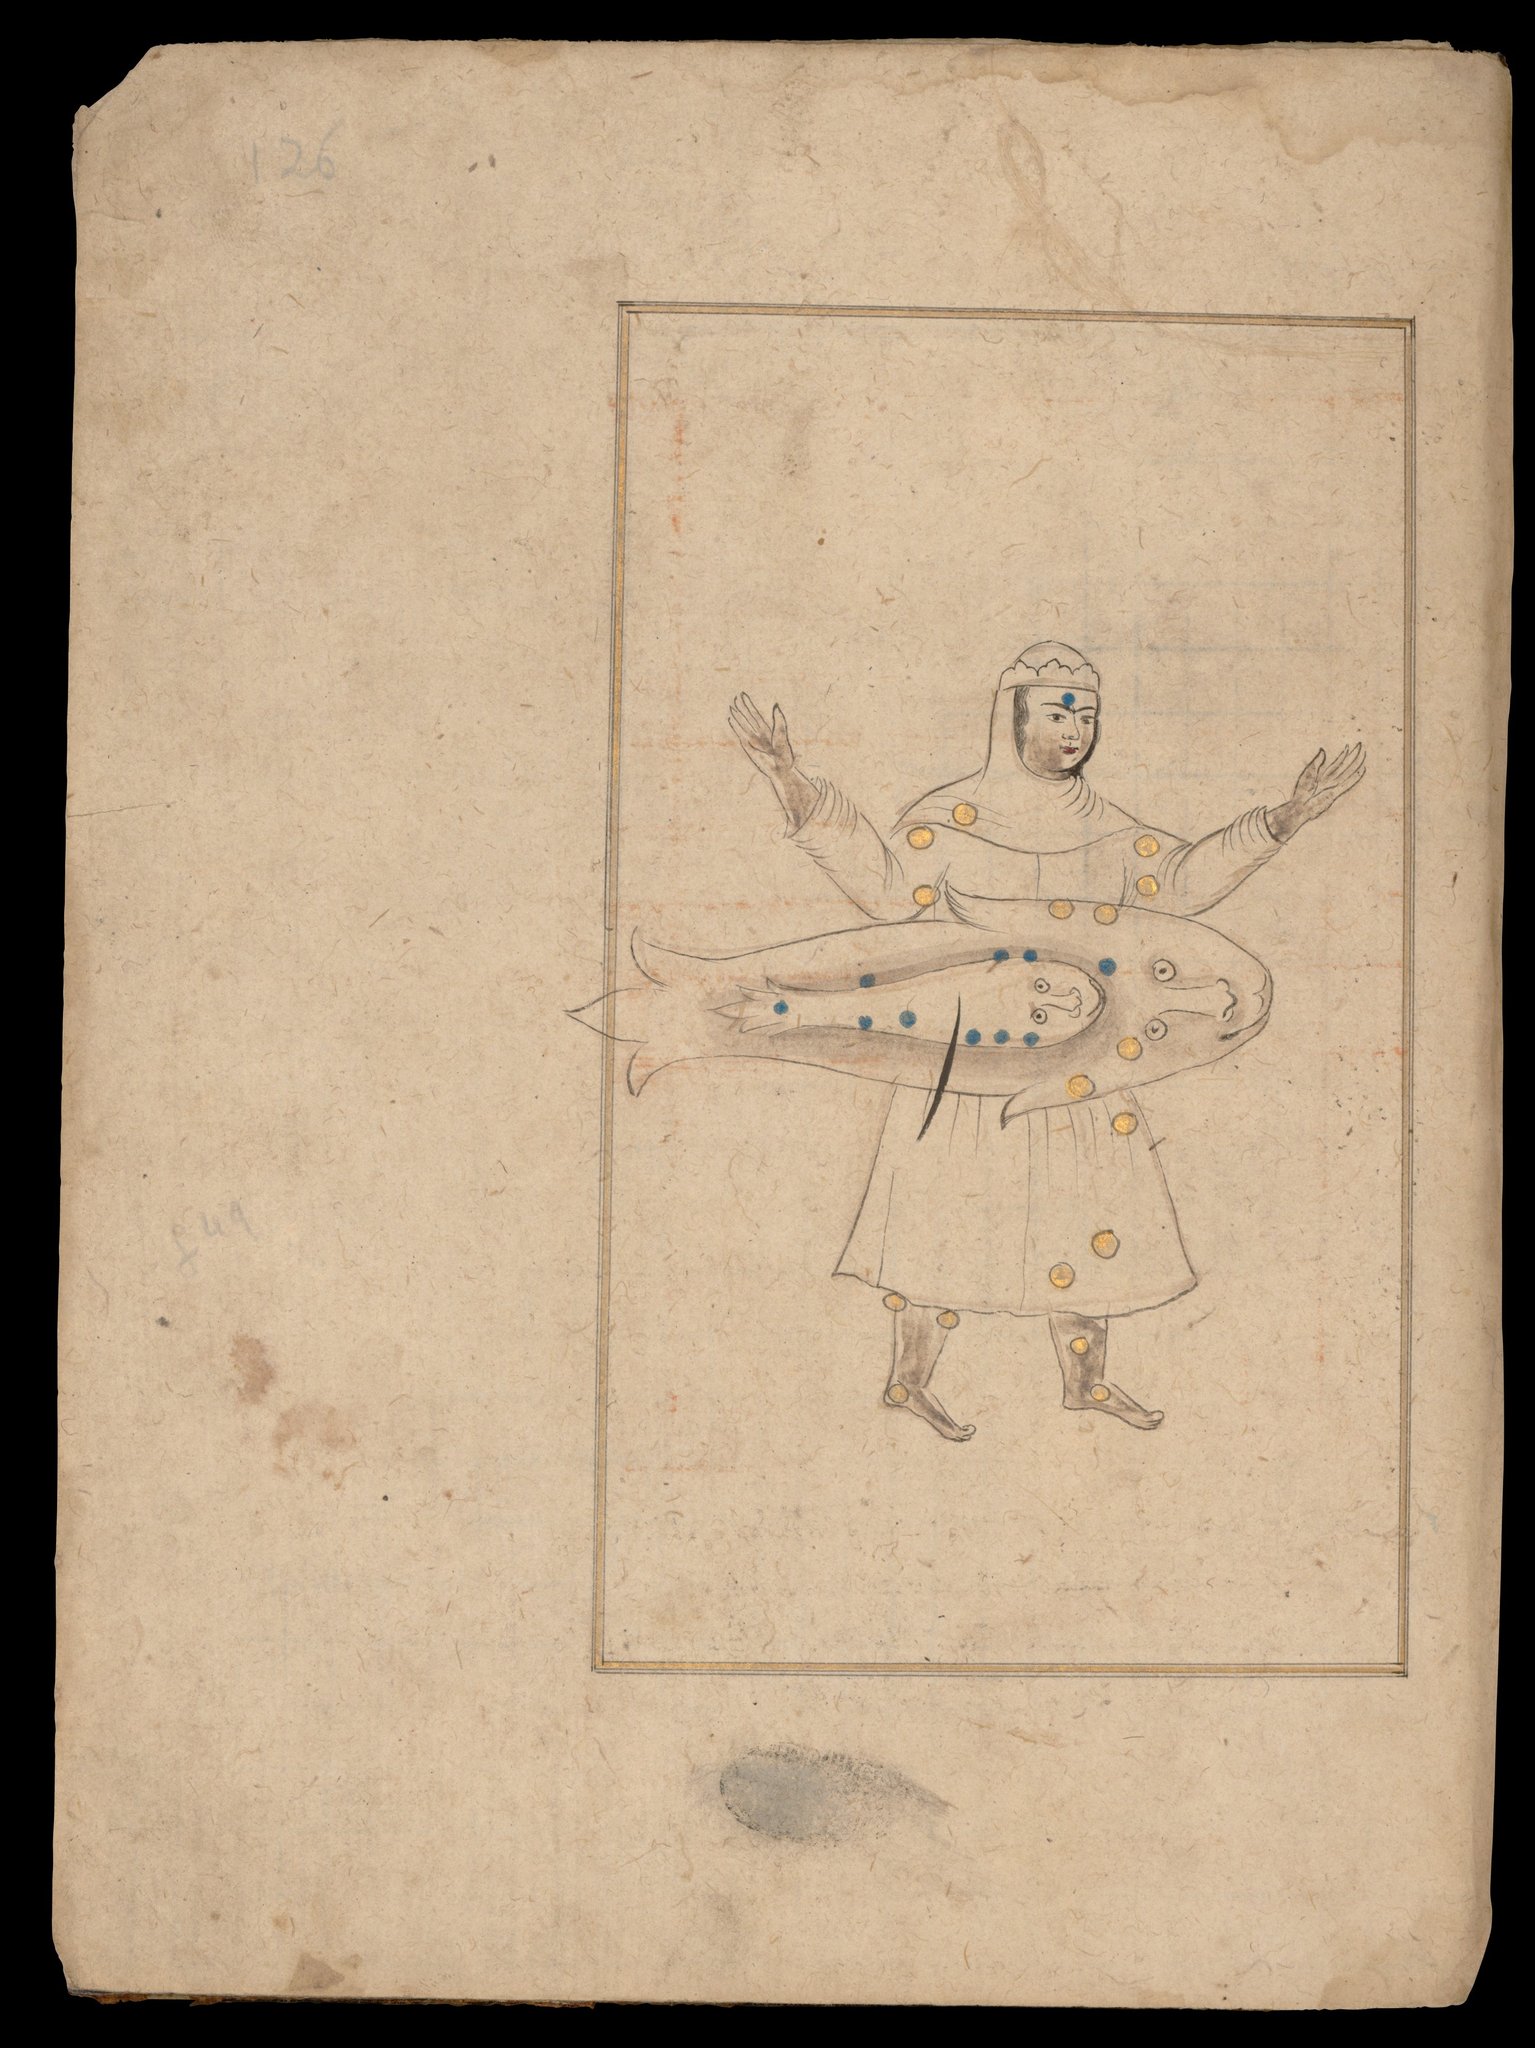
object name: illustrated manuscript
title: Kitab suwar al-kawakib al-thabita (Book of the Images of the Fixed Stars) of al-Sufi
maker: `abd al-rahman al-sufi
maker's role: author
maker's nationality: iranian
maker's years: 903-986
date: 1701-1800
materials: gold, ink, paper, watercolor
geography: iran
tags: men,fish,serpents